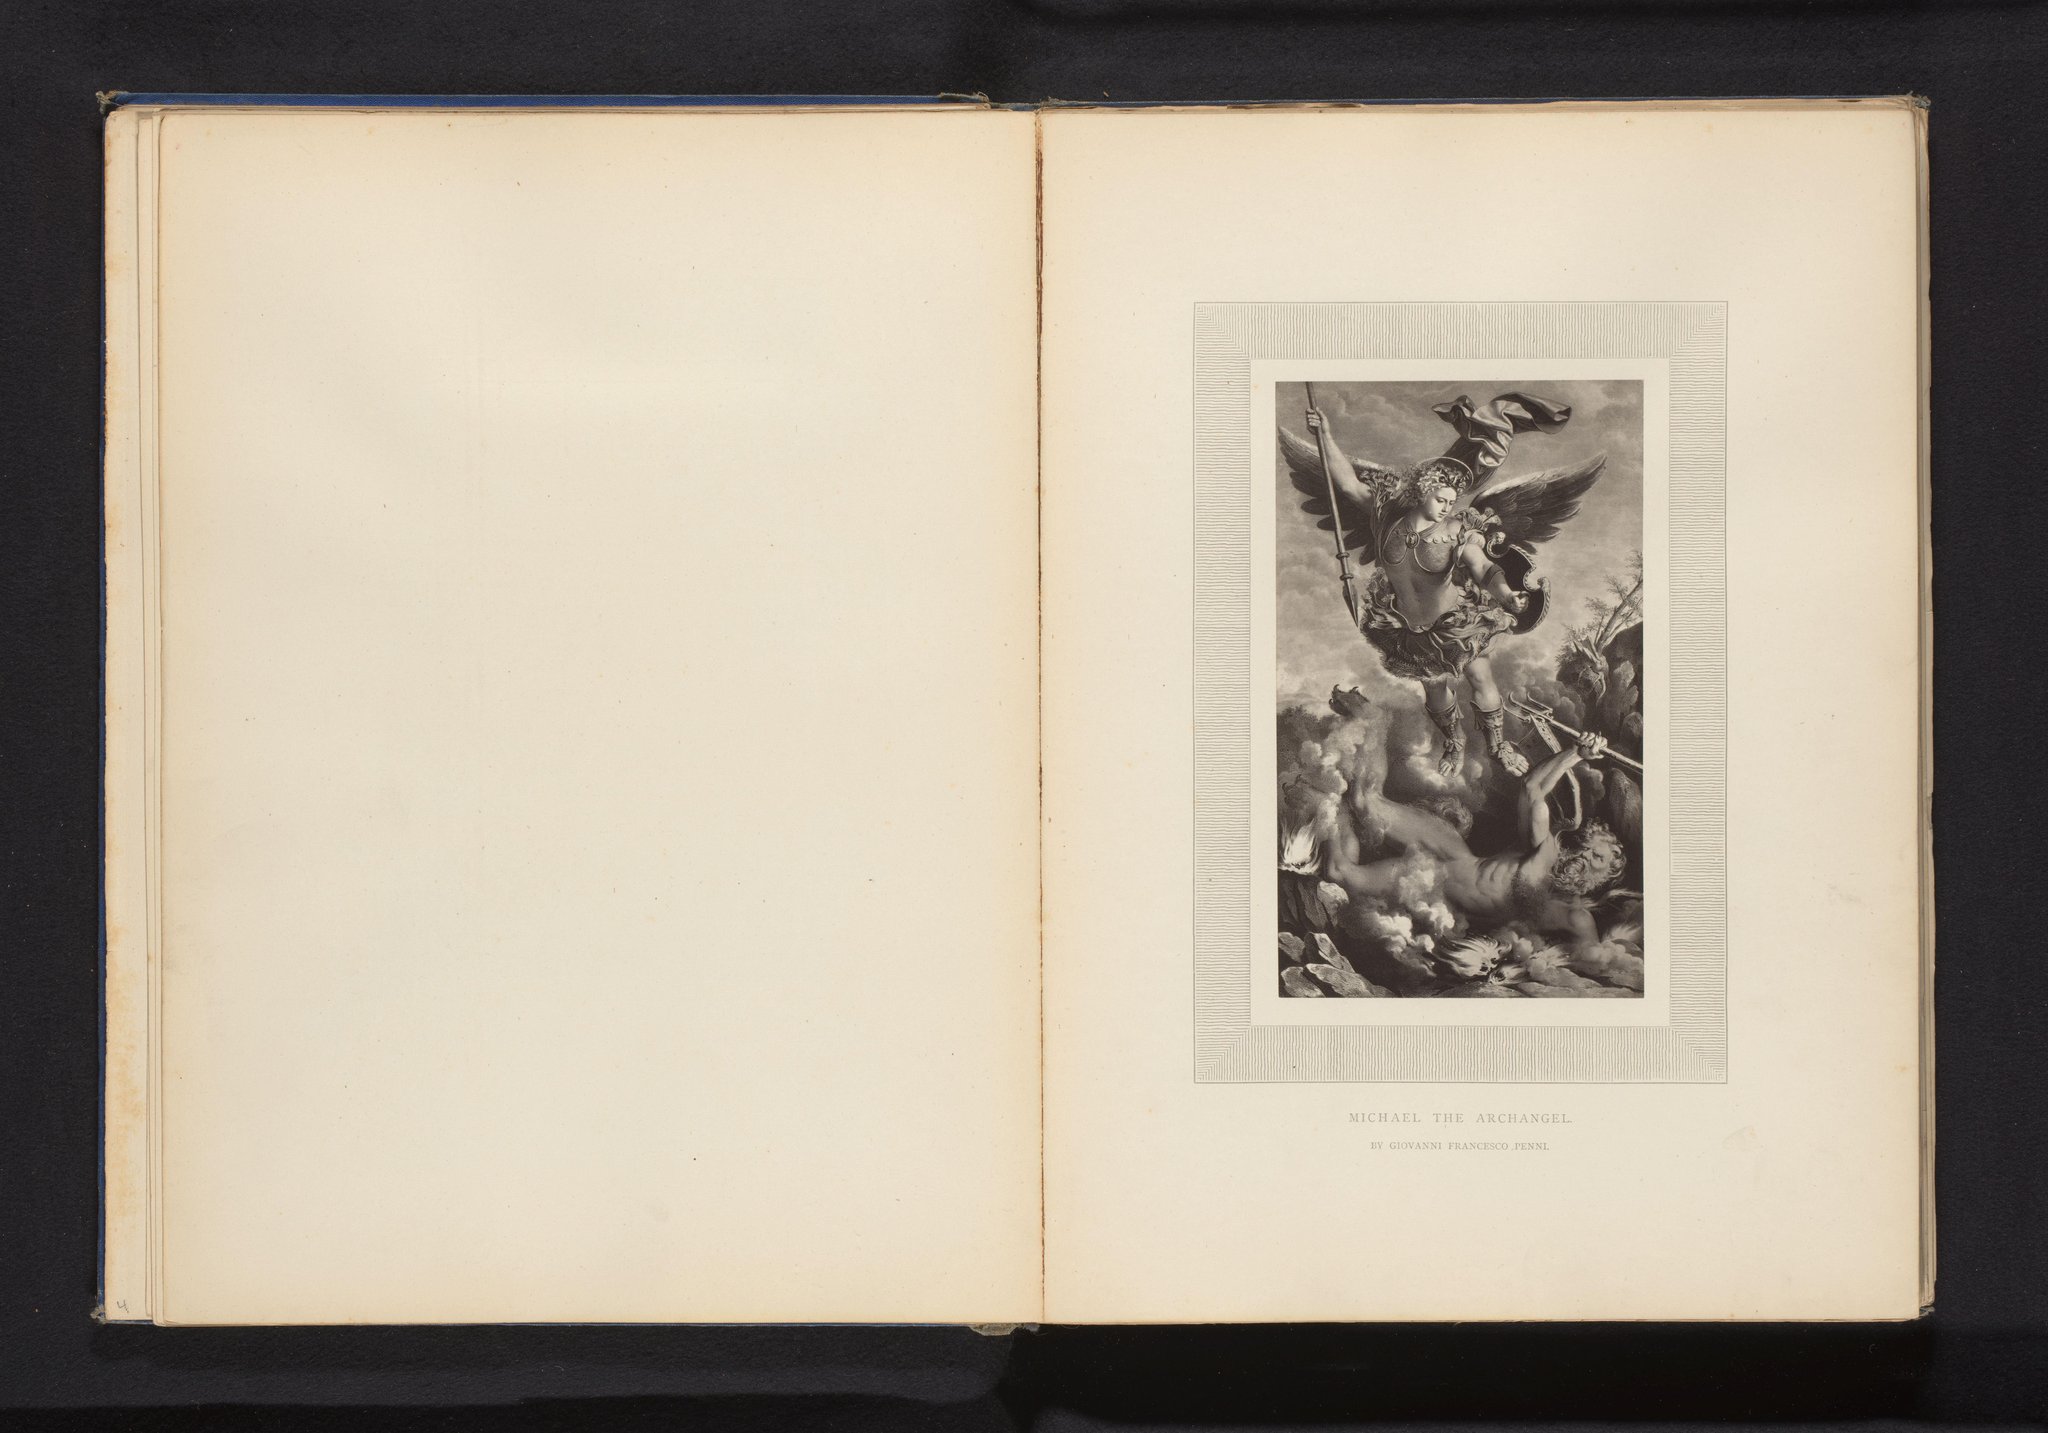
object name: page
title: Reproductie van een prent van de aartsengel Michaël door Franz Hanfstaengl naar Giovanni Francesco Penni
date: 1870-1875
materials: paper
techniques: woodburytype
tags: the archangel michael (often in armour with sword or lance)